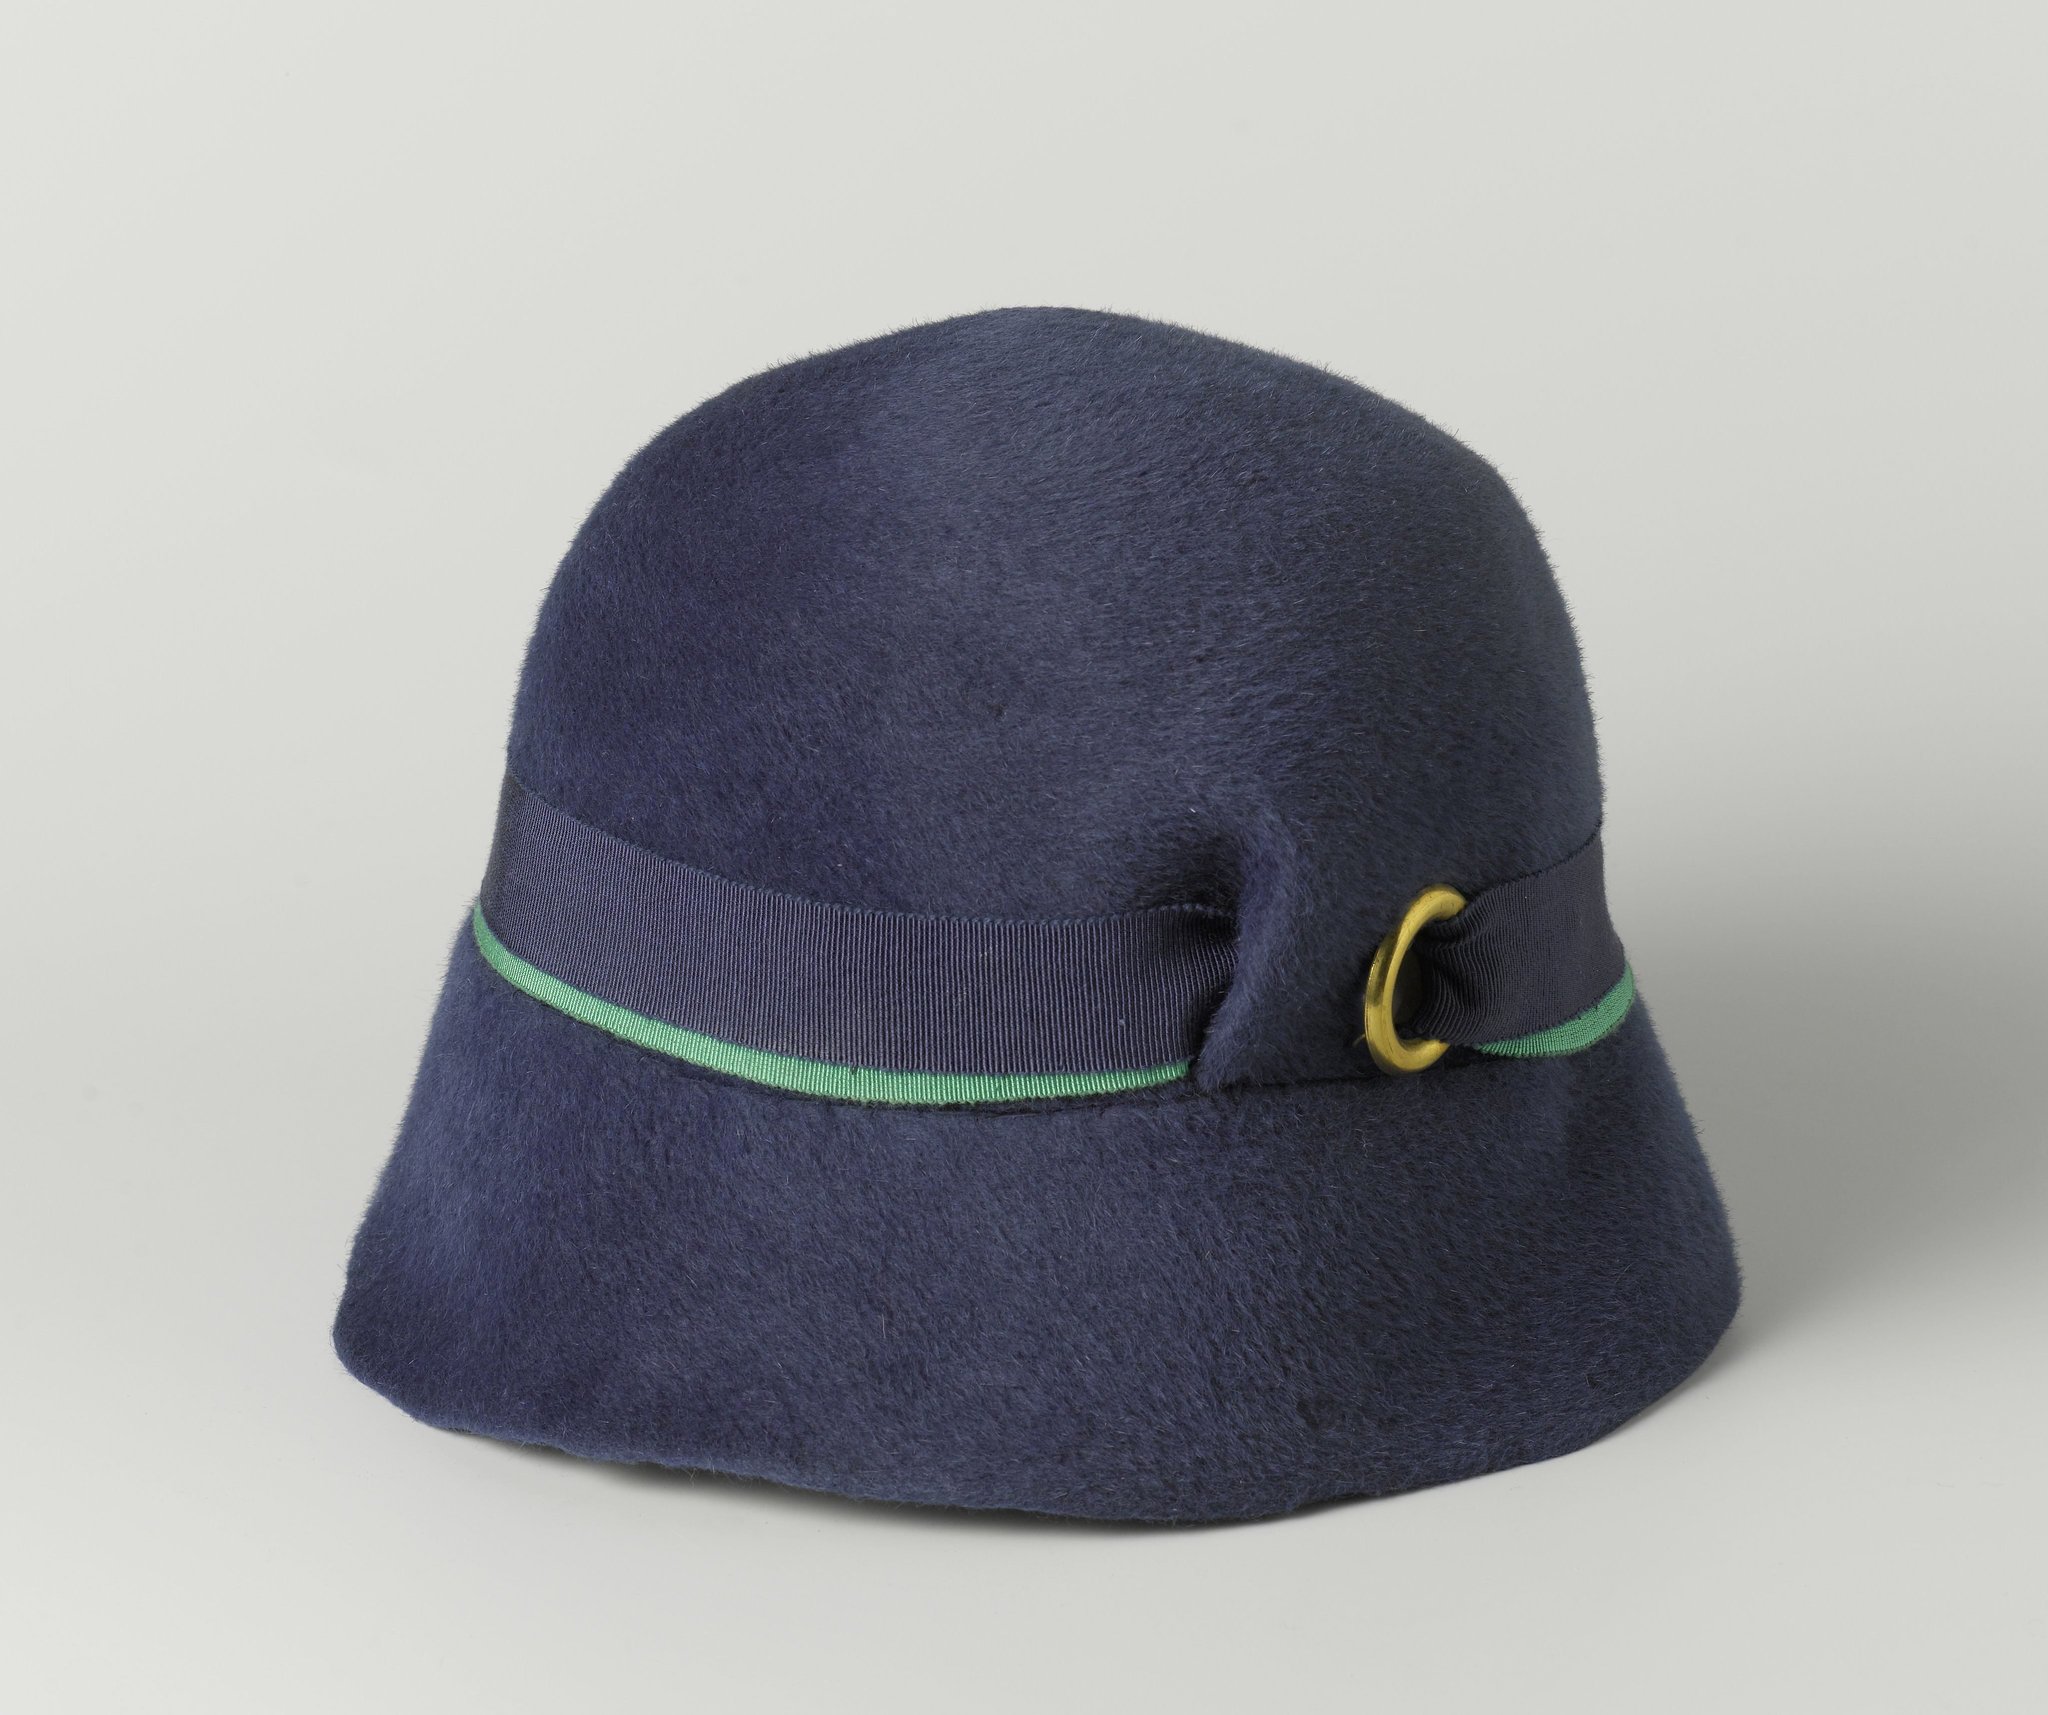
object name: womenswear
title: Cloche van blauw haarvilt met een dubbele ripsband in groen en blauw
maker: katja robinski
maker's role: hoedenmaakster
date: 1958-1965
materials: cotton, felt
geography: amsterdam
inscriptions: mark: ‘Katja Robinski Amsterdam’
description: Cloche van blauw haarvilt met een dubbele ripsband in groen en blauw en geelkoperen ring.